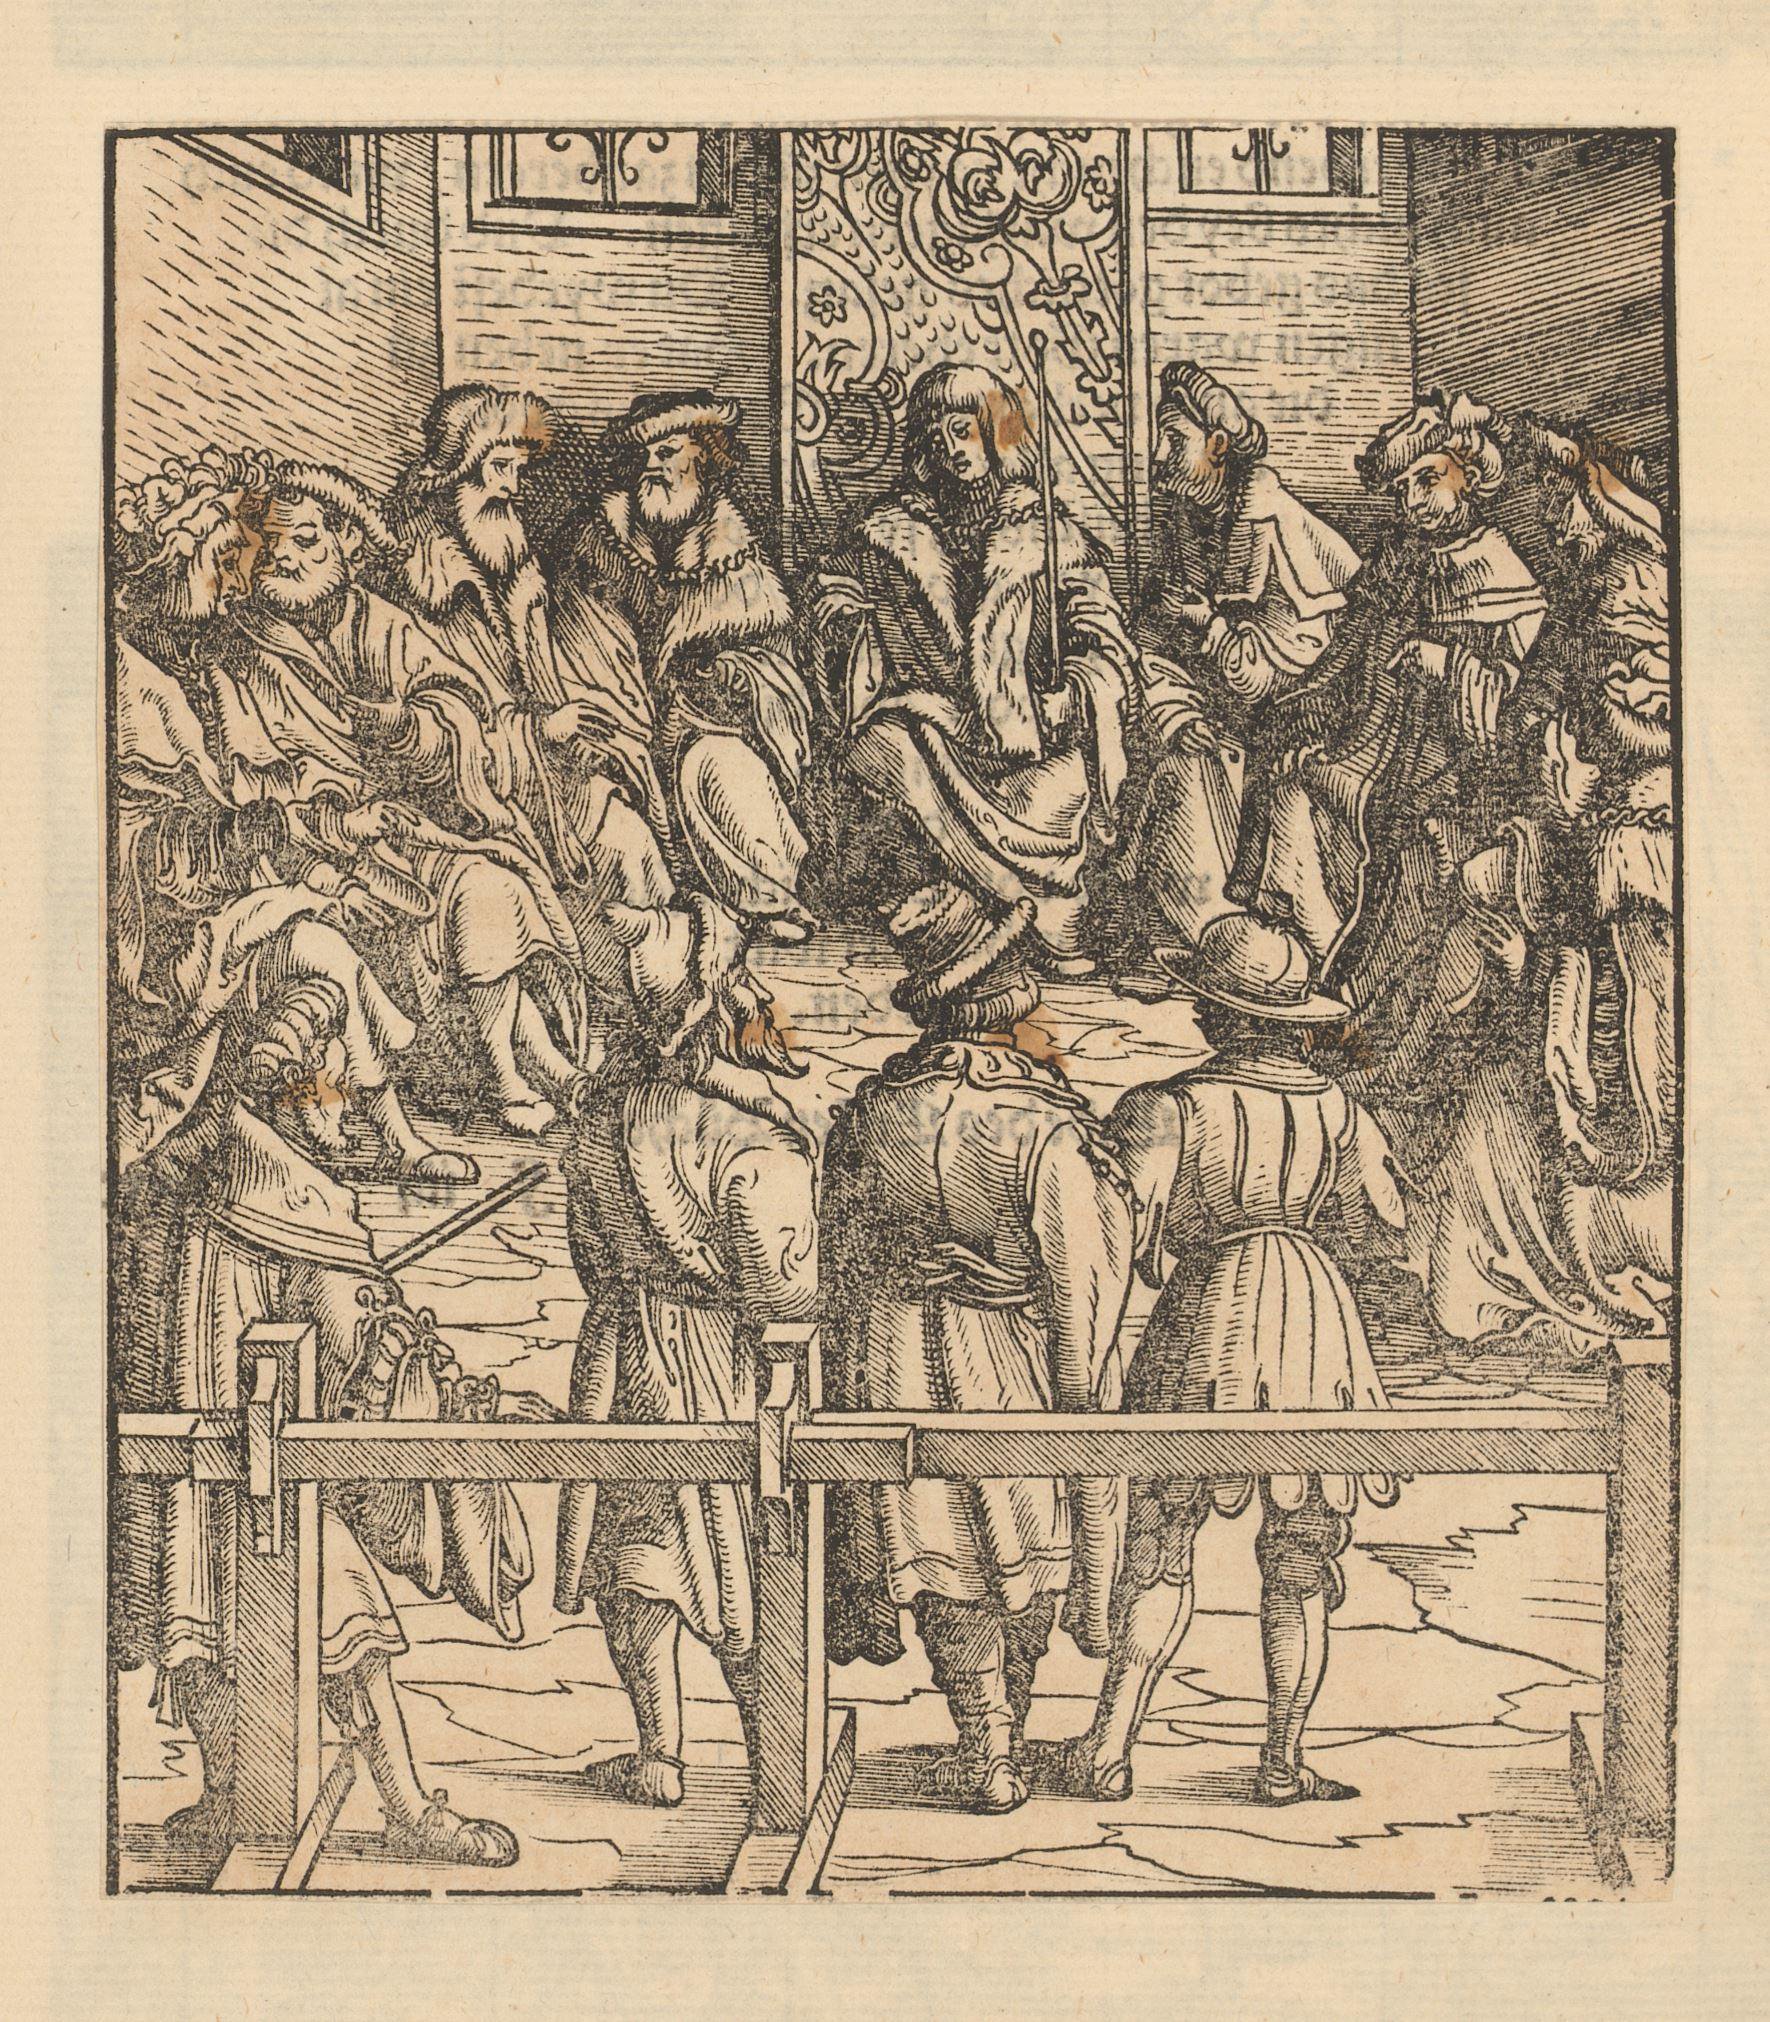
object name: book illustration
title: Mannen in een raadzaal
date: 1483-1531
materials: paper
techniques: letterpress printing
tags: assembly-room, counsellor